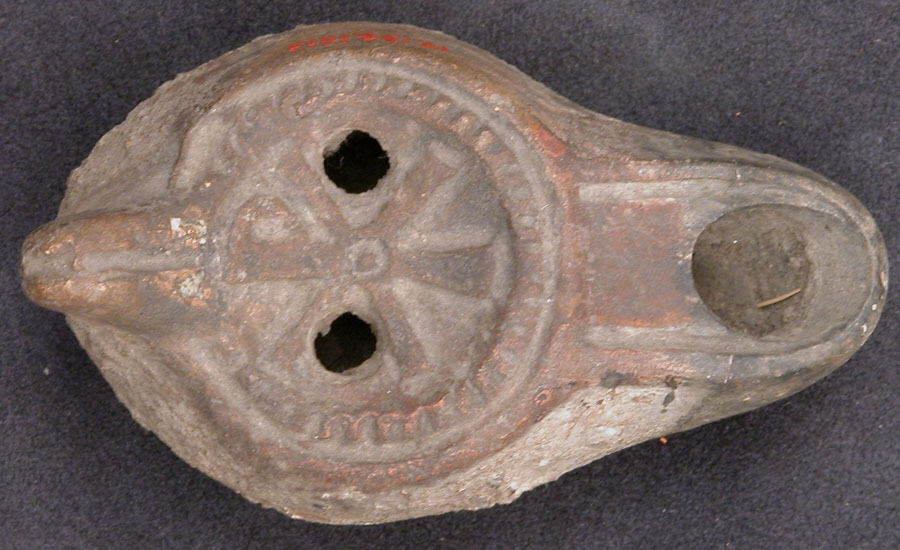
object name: lamp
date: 201-700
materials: earthenware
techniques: molding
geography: egypt